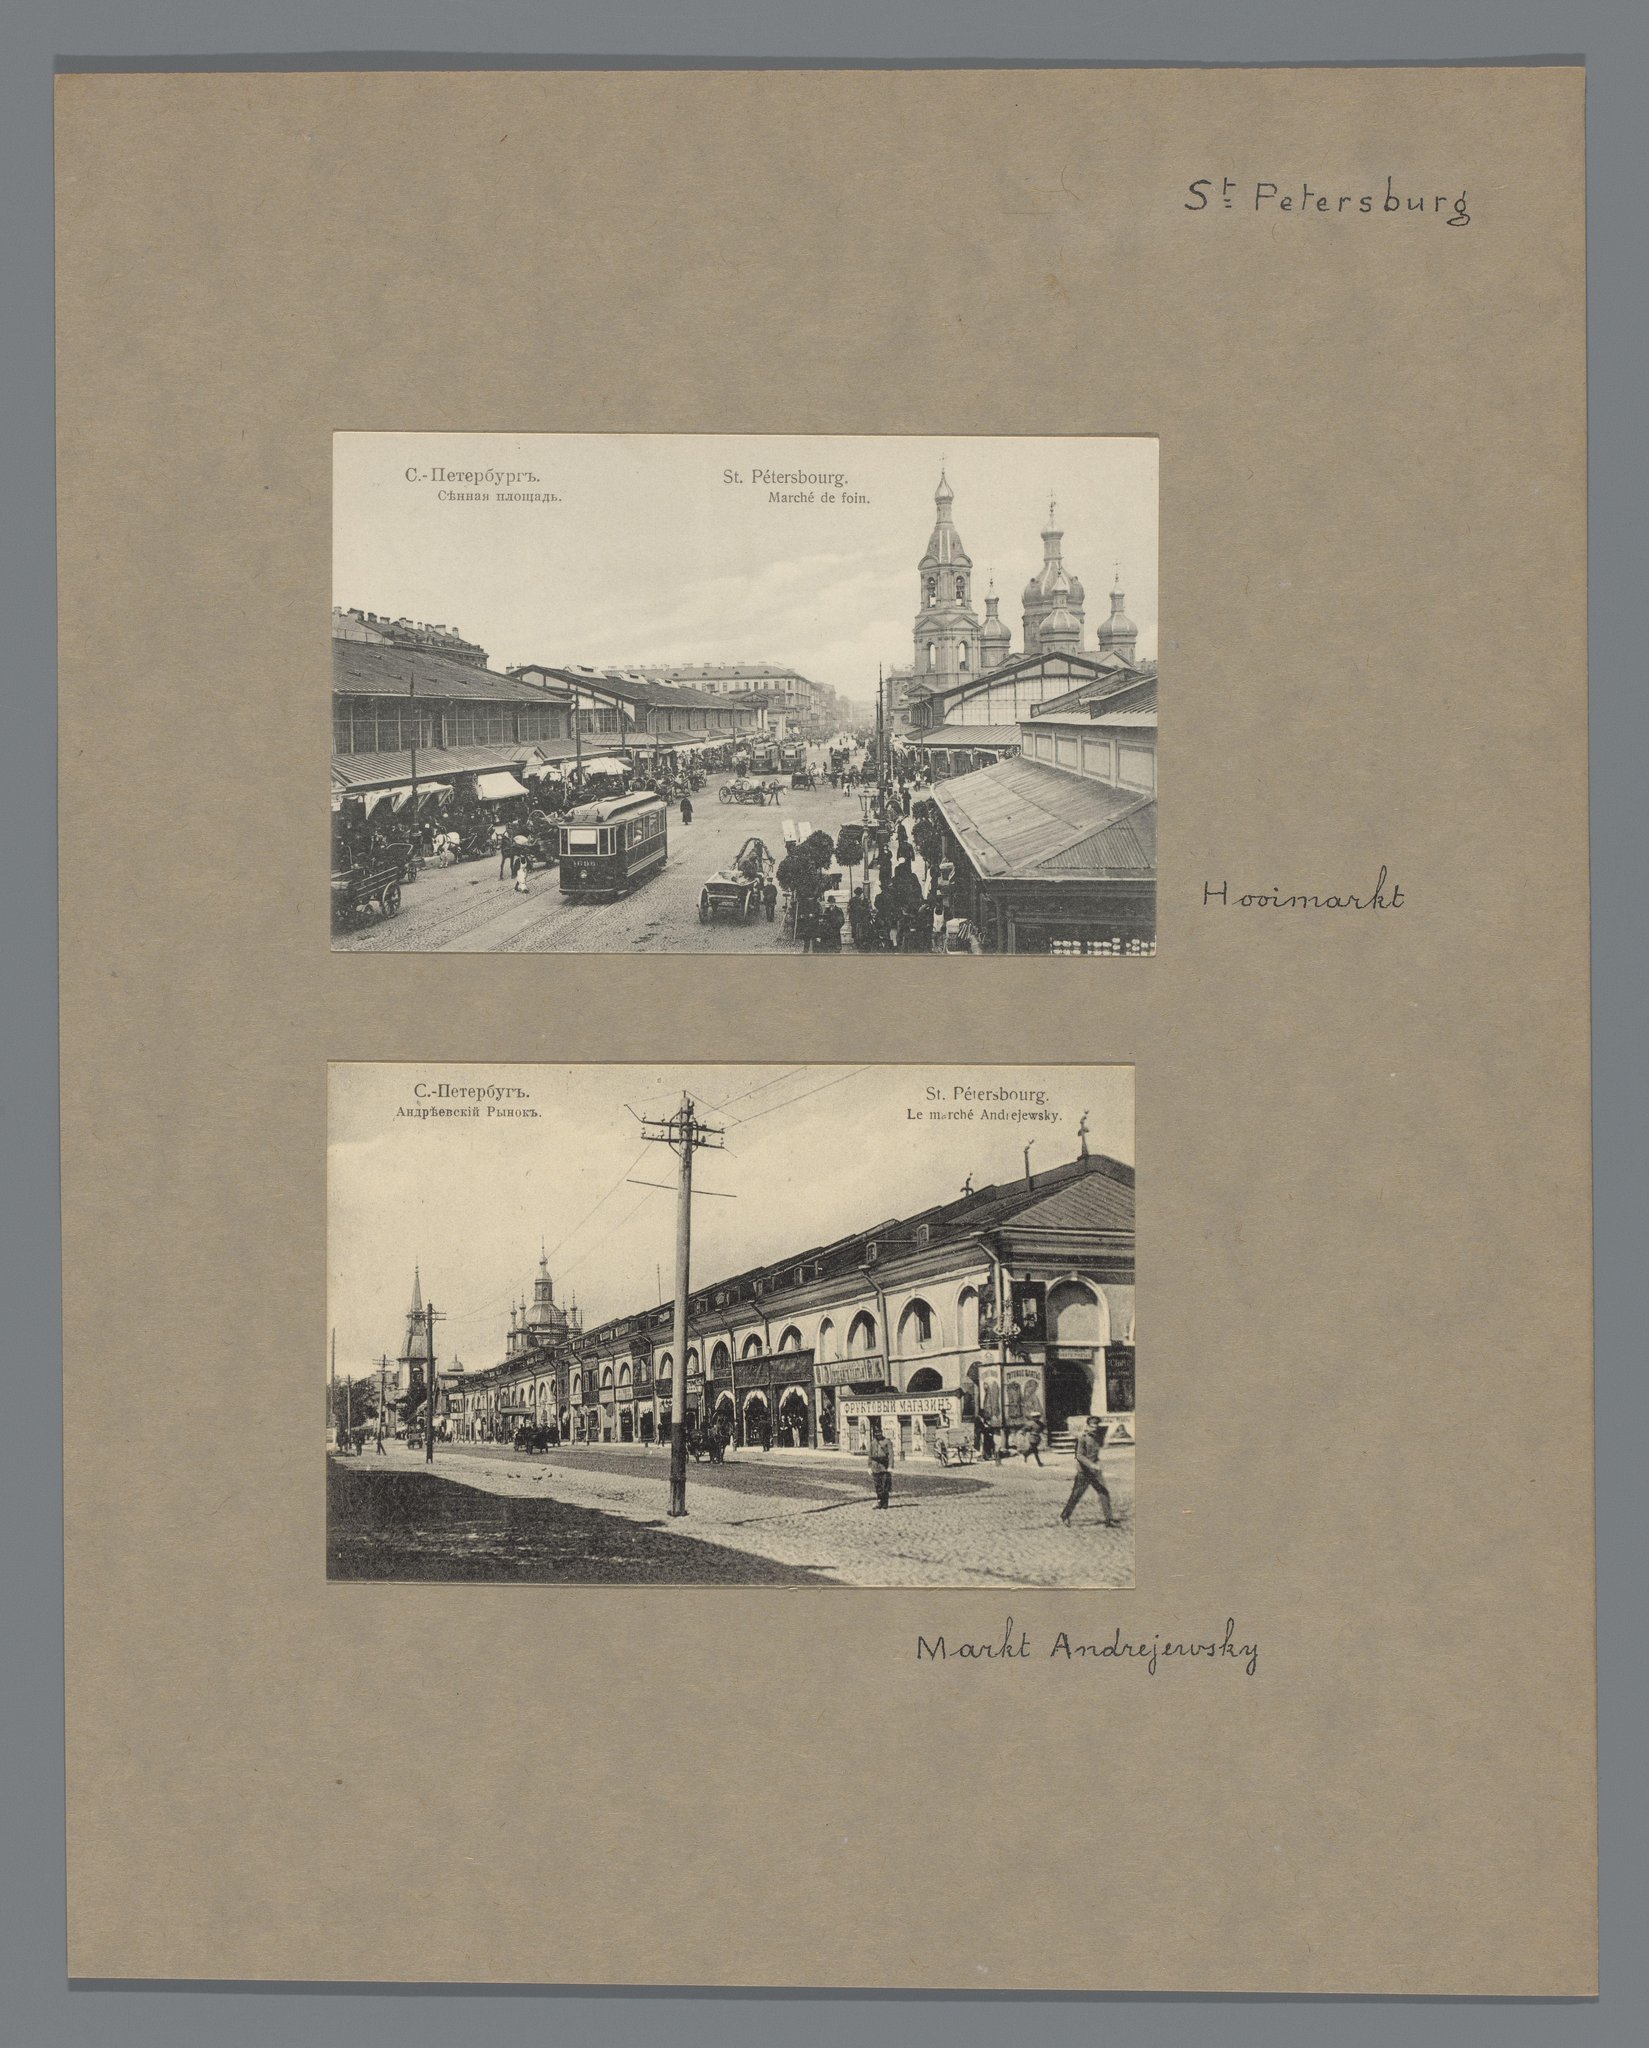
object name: photograph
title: St. Petersburg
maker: Anonymous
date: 1860-1925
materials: photographic support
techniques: photograph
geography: russia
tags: sint-petersburg